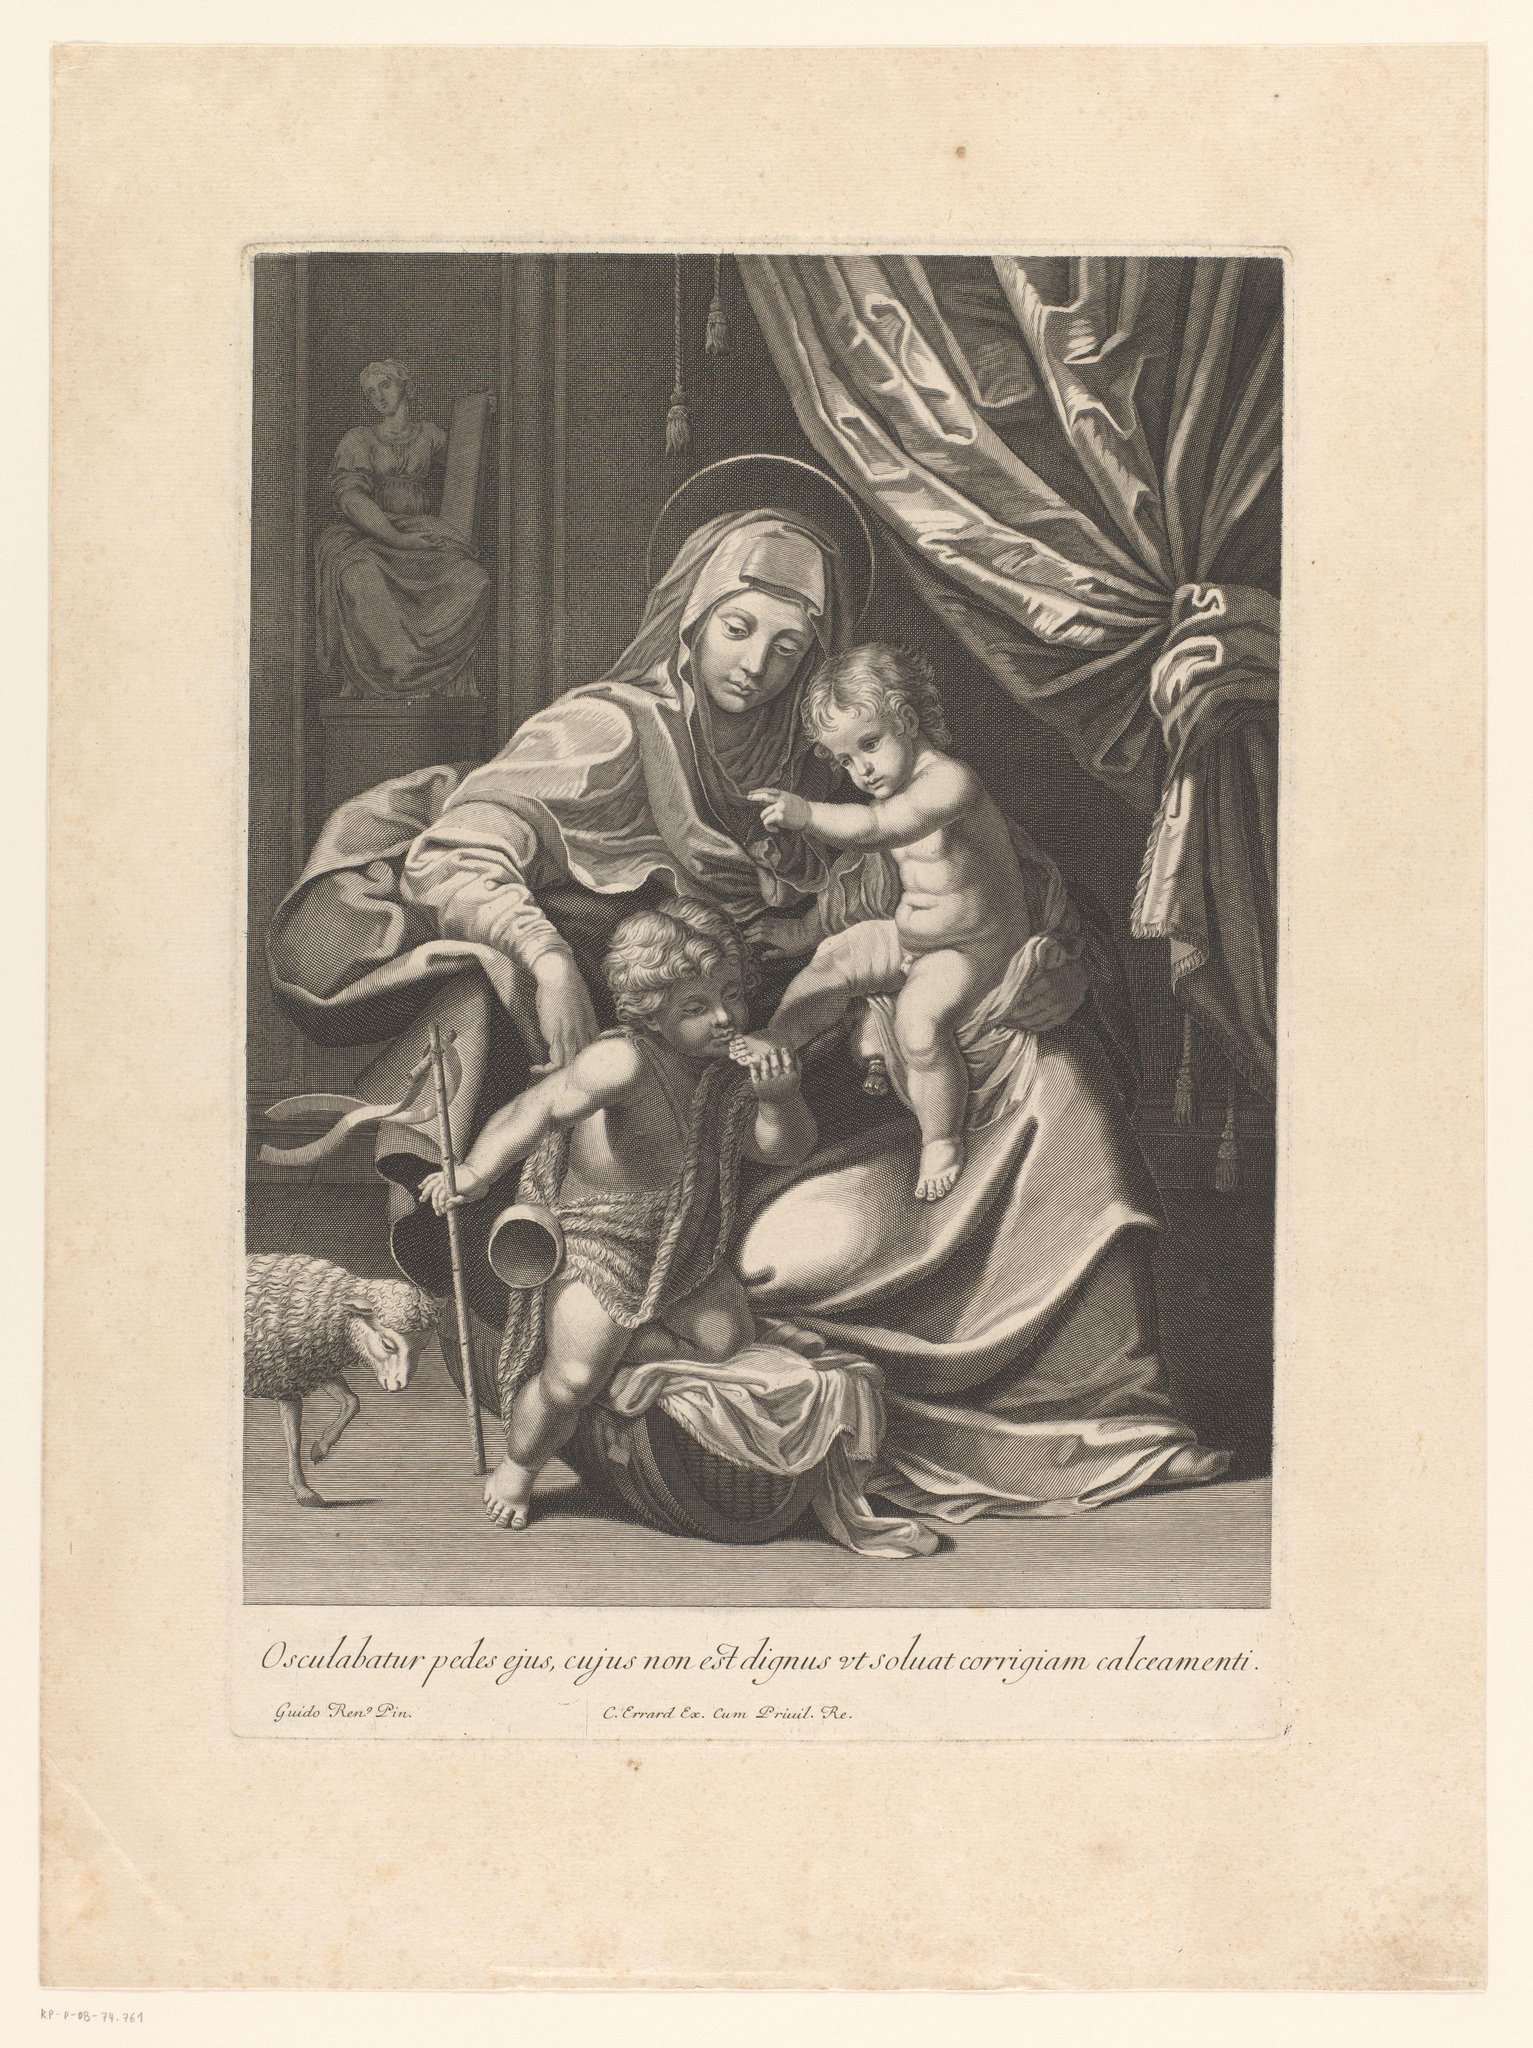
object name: print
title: Maria met Kind en Johannes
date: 1616-1689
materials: paper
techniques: engraving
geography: france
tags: mary and the christ-child with john the baptist (as child)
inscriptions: collector's mark: Lugt 240